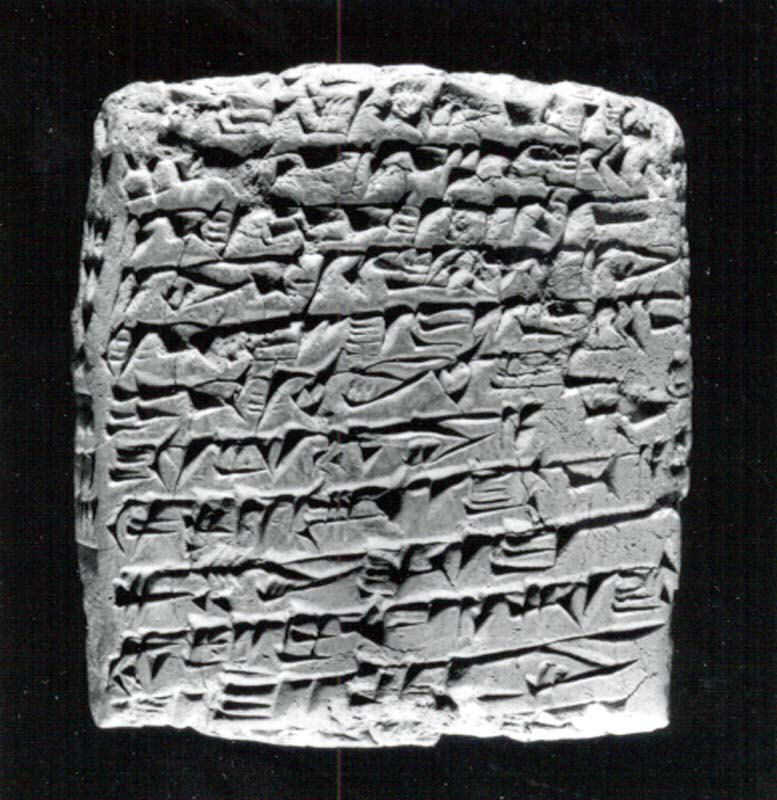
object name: cuneiform tablet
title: Cuneiform tablet: private letter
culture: assyrian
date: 2000-1801 BCE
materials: clay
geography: anatolia